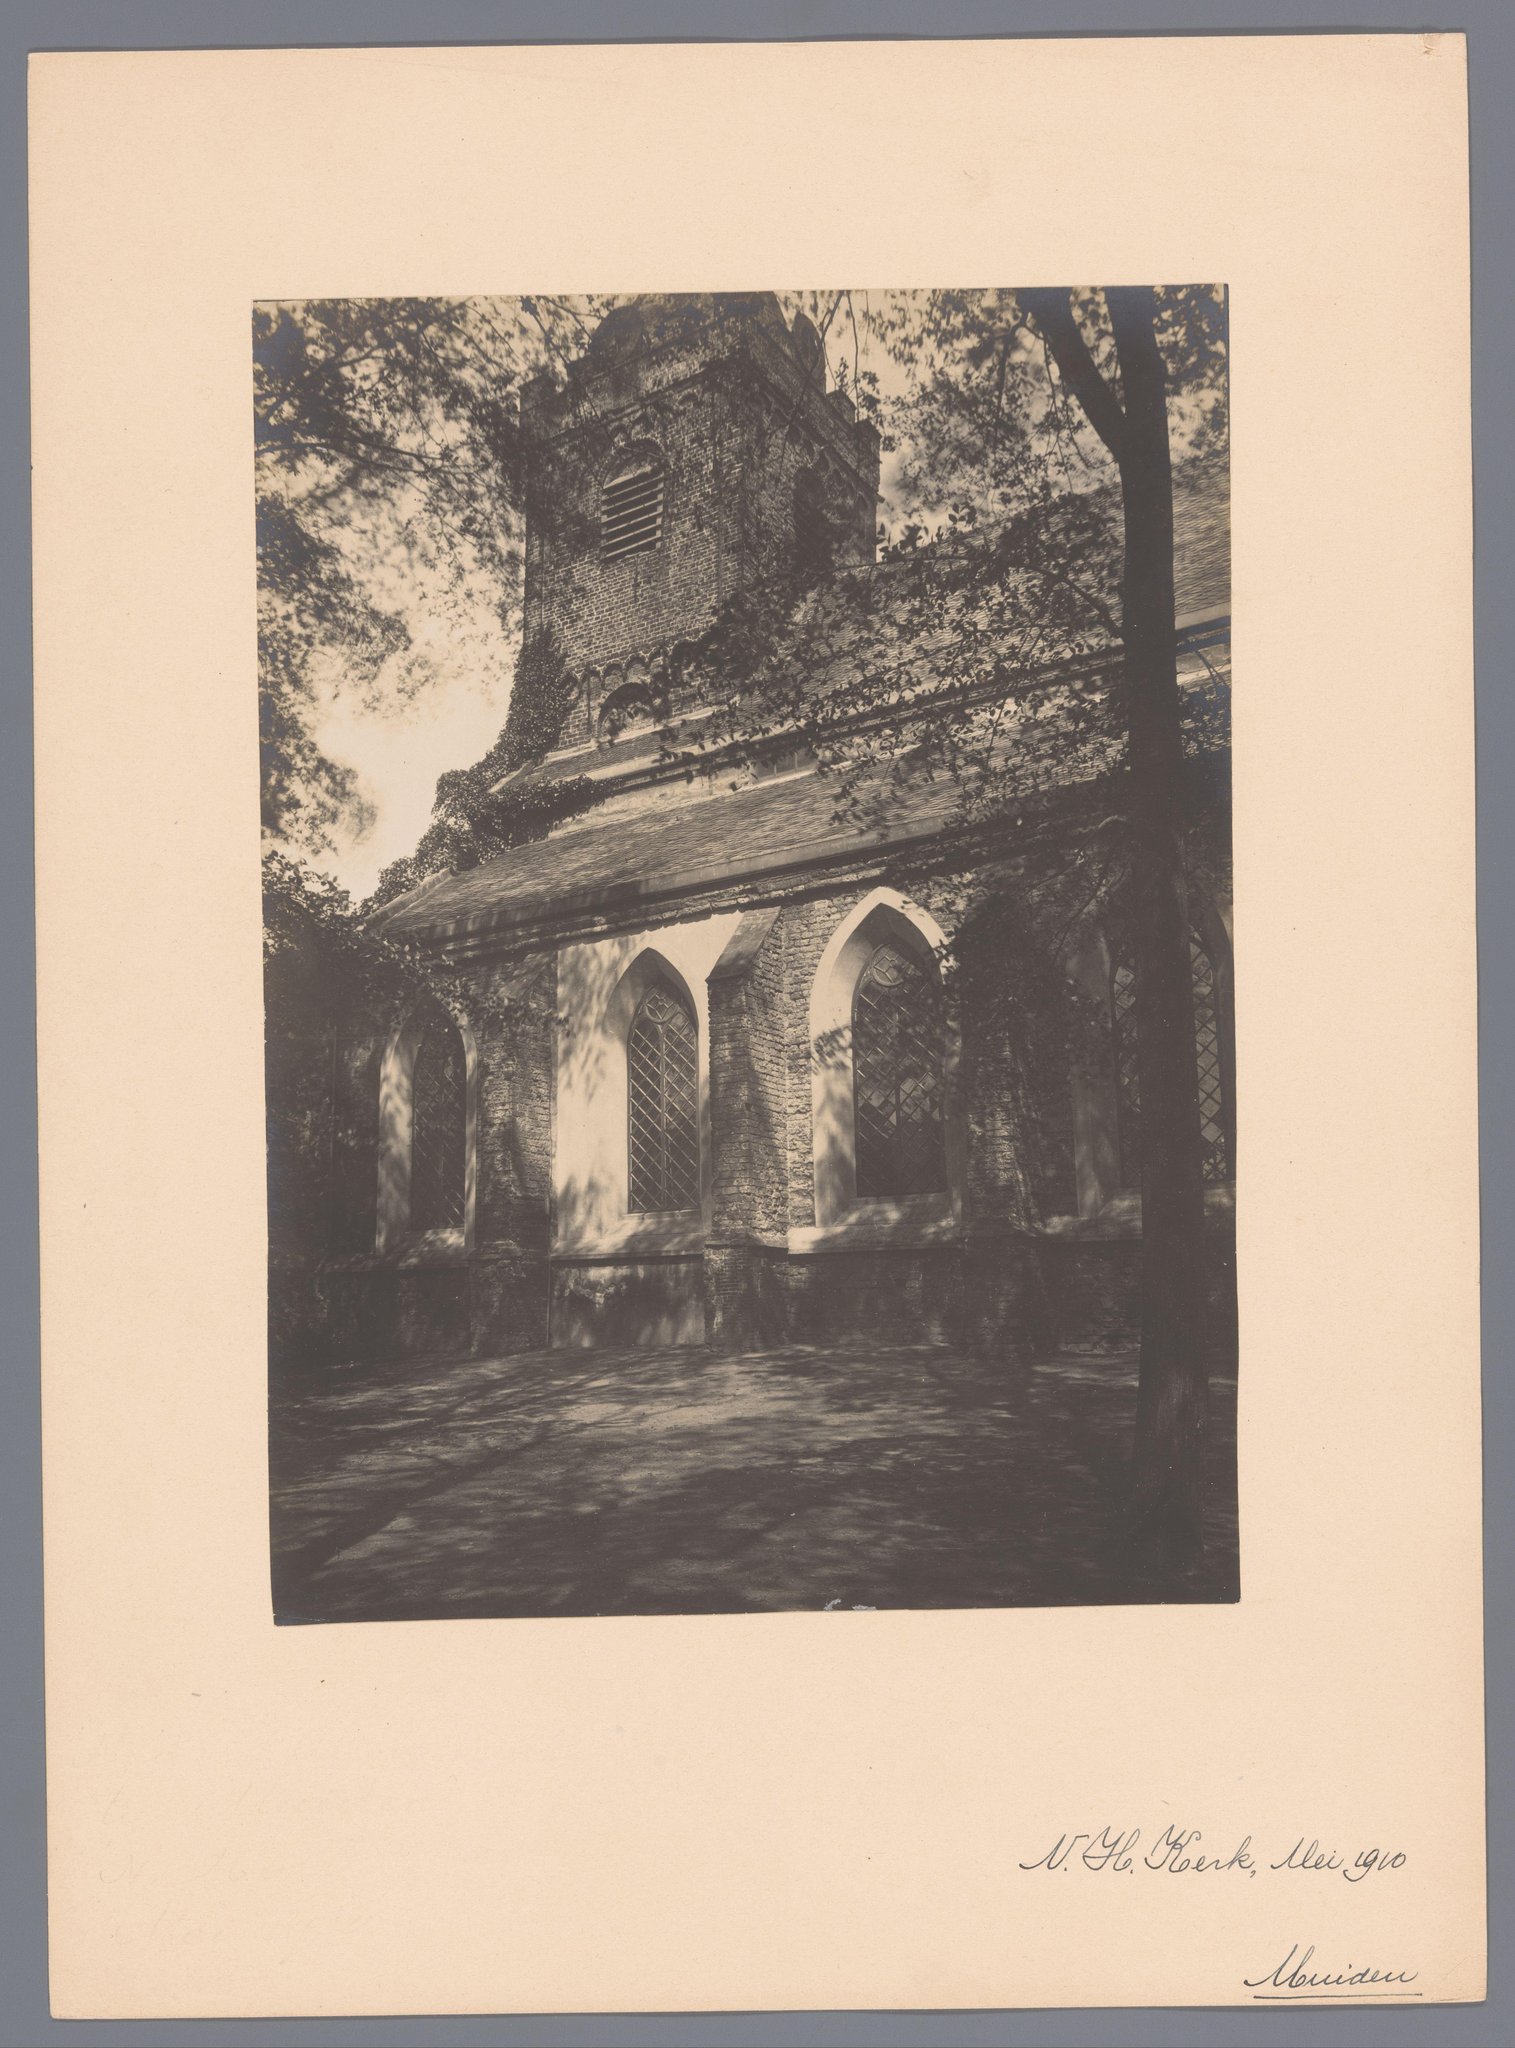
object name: photograph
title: Grote Kerk te Muiden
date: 1910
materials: cardboard, photographic support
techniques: gelatin silver print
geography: muiden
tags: church (exterior)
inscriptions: annotation: ‘N.H. Kerk, Mei 1910/ Muiden’